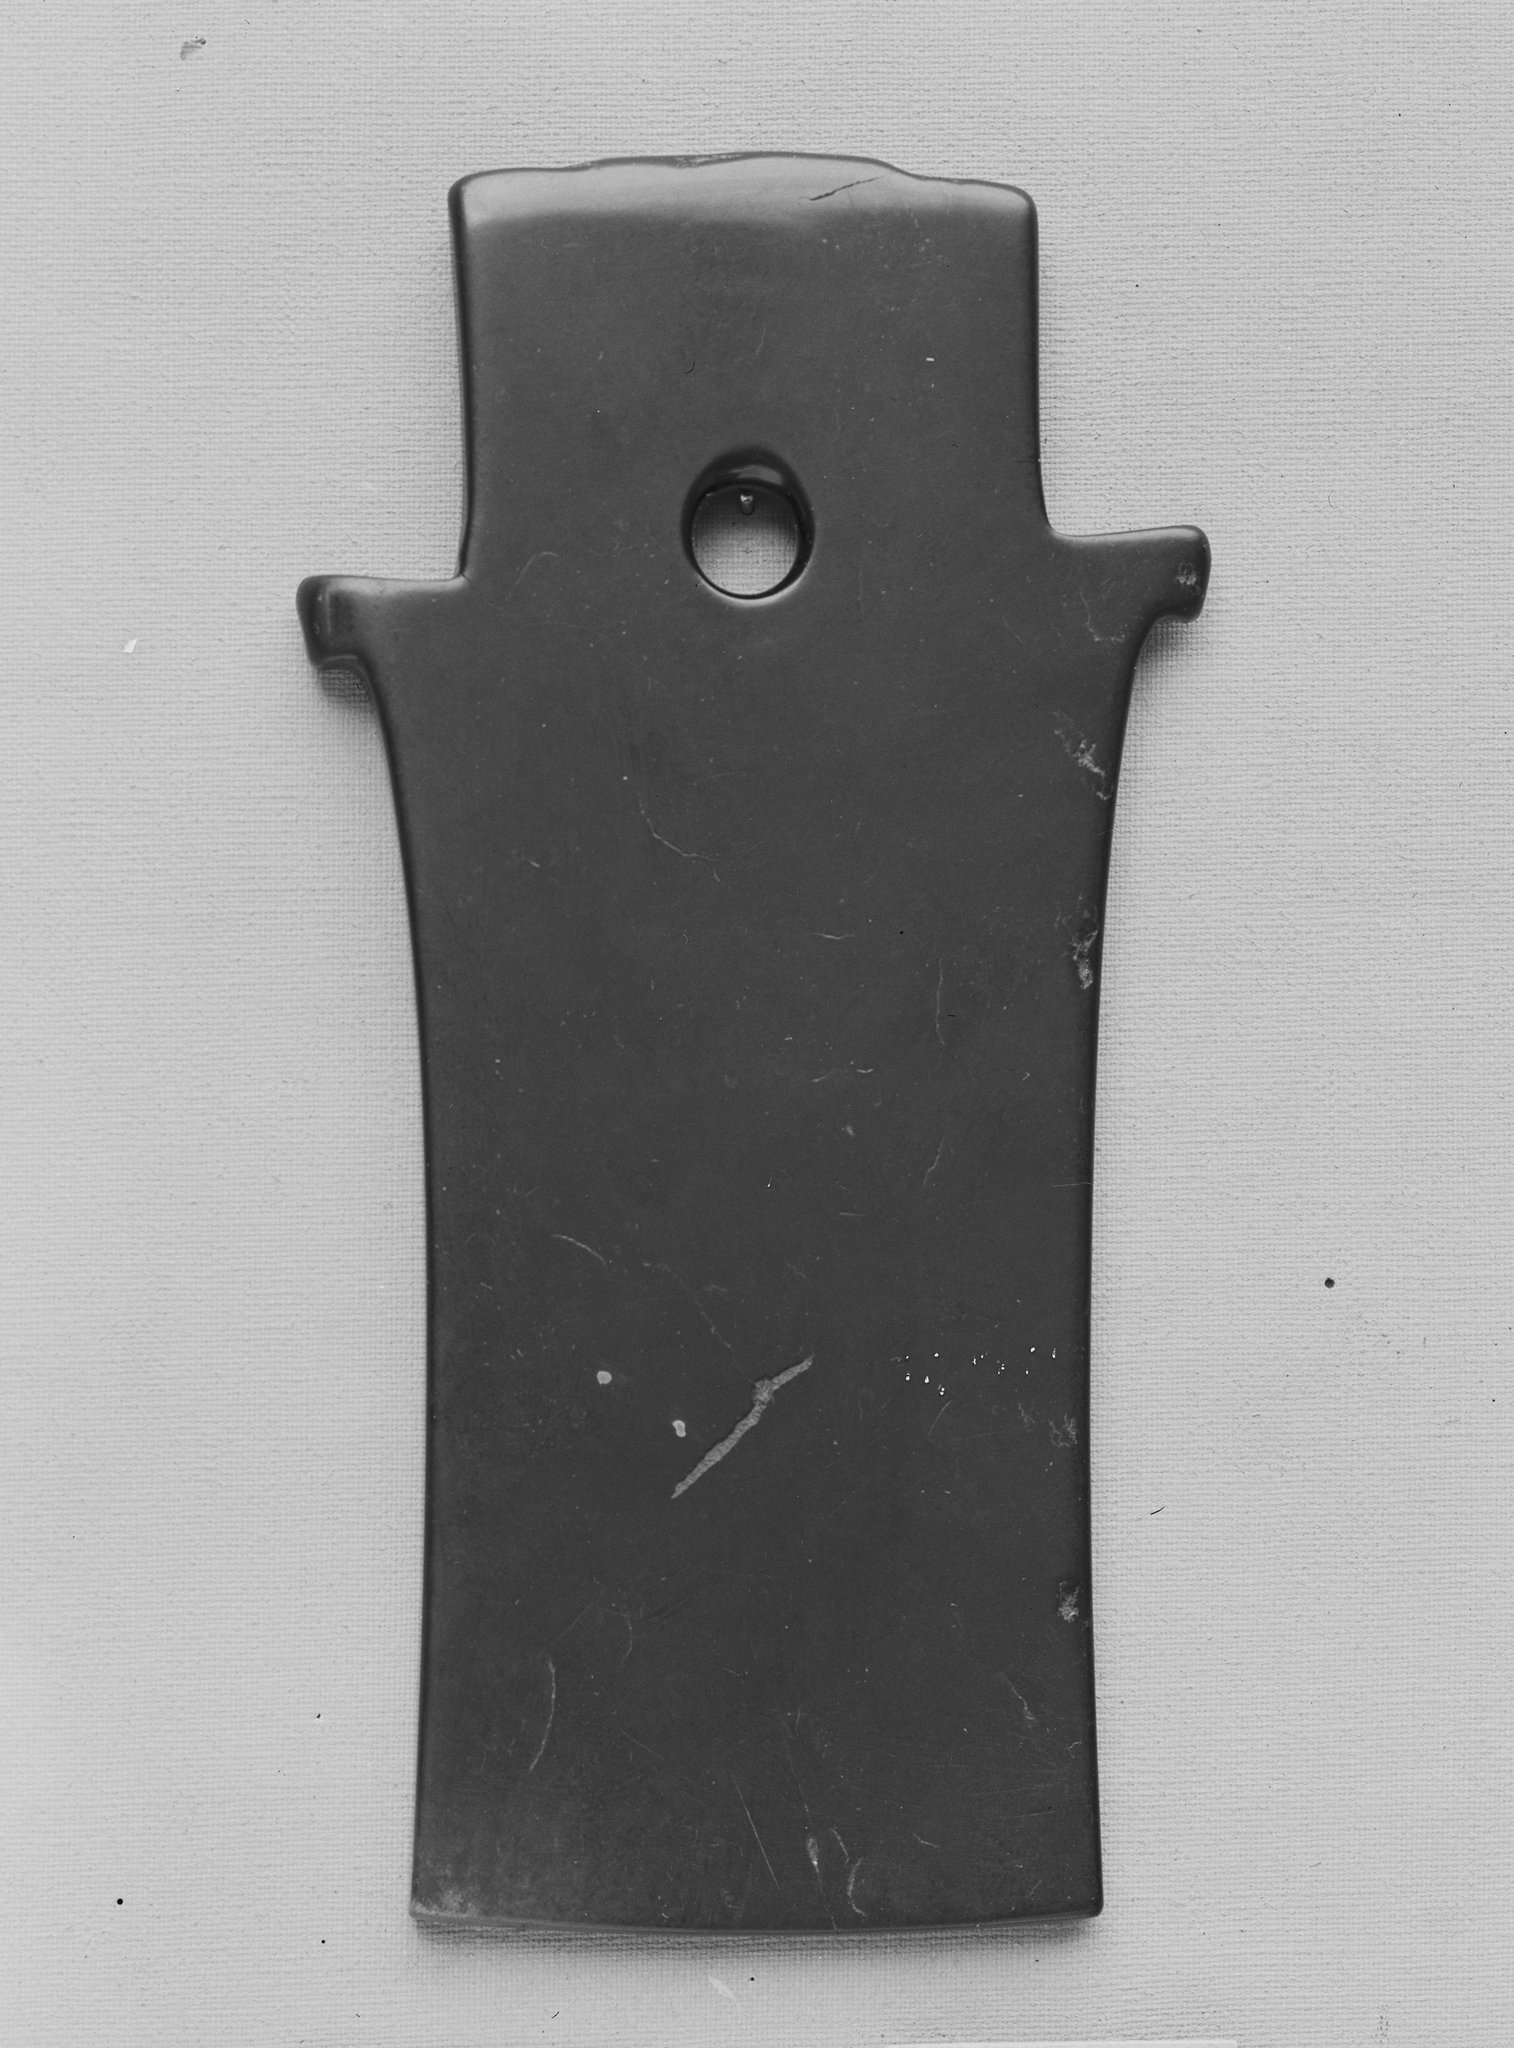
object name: hatchet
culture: chinese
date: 206 BCE-220 CE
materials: jade